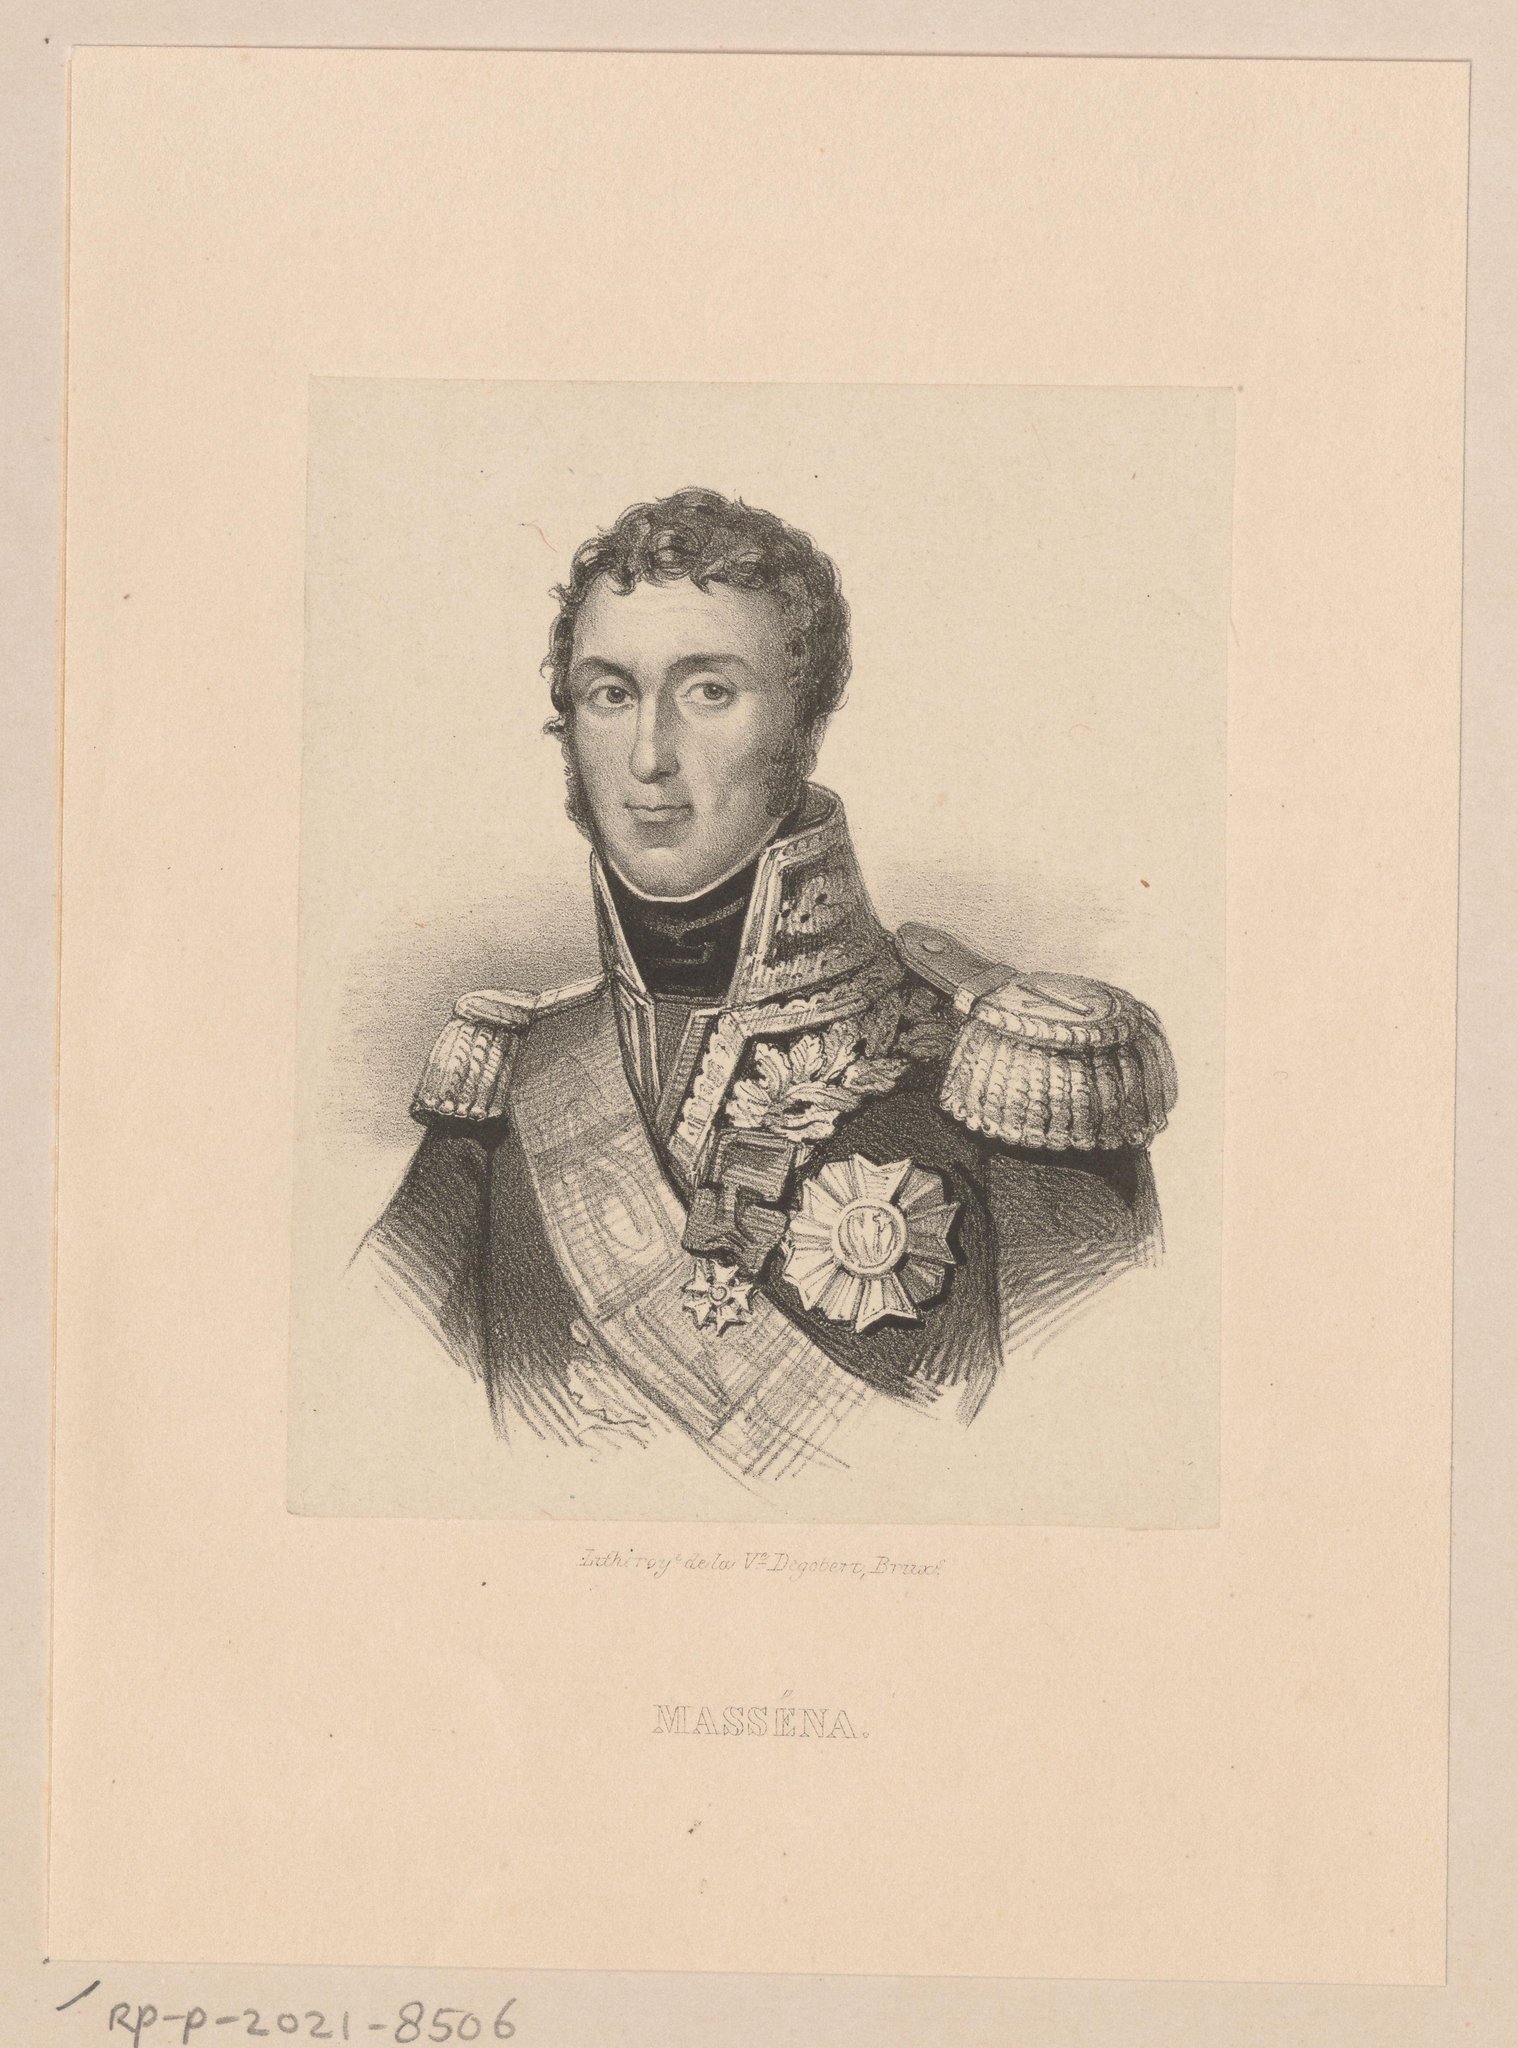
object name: print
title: Portret van André Masséna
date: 1844-1849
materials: paper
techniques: lithograph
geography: brussels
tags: commander-in-chief, general, marshal, historical persons, (military) uniforms